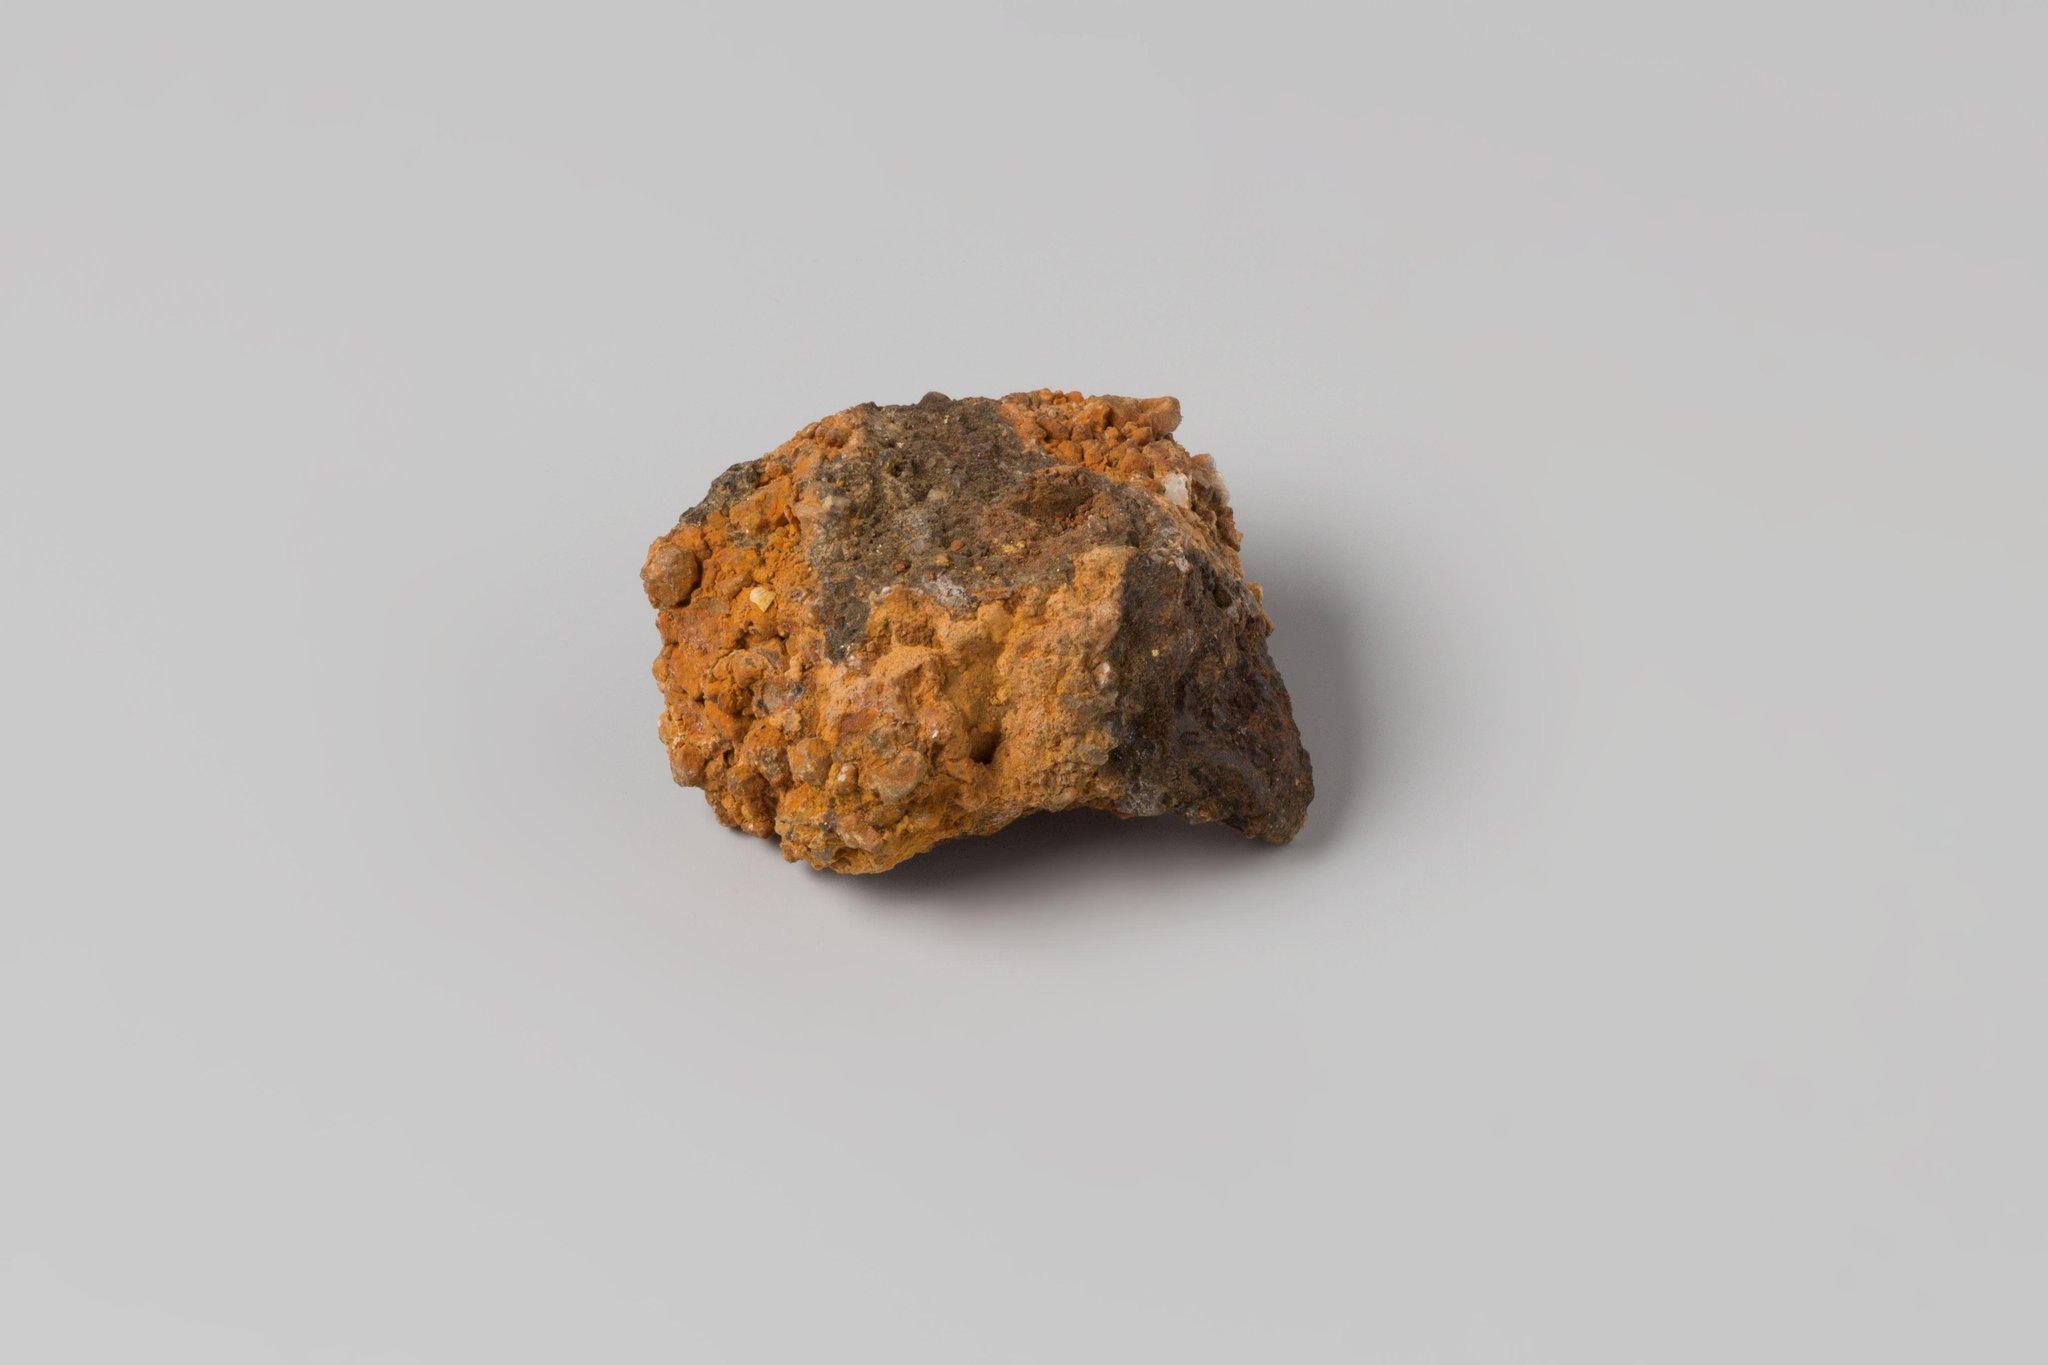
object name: concretionary stone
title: Concretie uit het wrak van de Oost-Indiëvaarder Hollandia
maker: Anonymous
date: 1700-1743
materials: stone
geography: netherlands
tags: verenigde oostindische compagnie, hollandia (schip), annet